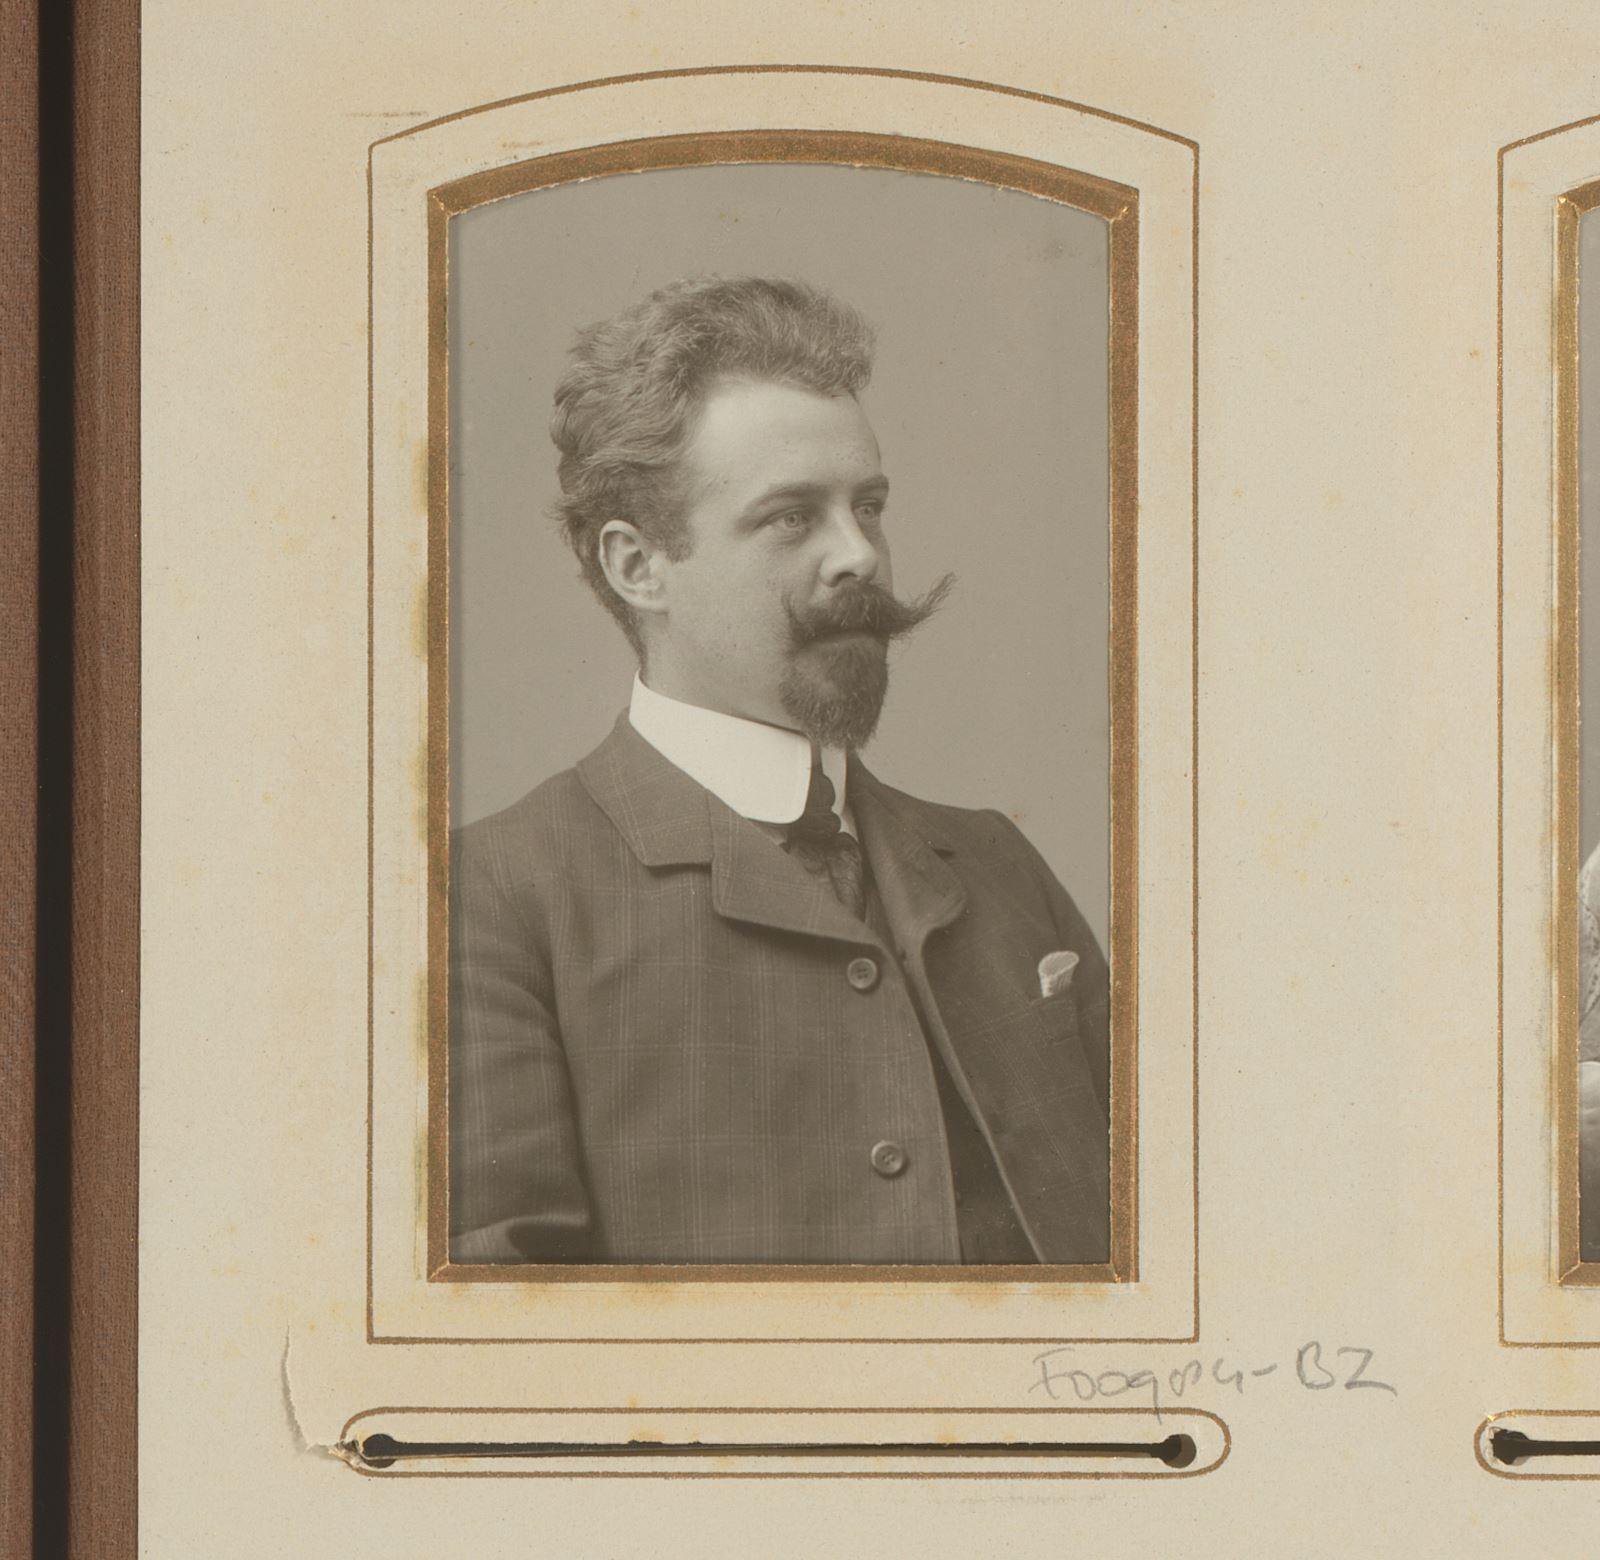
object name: album leaf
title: Portret van een man met snor en sik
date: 1905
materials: cardboard, photographic support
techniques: collodion silver print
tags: moustache, historical persons, beard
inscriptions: date: ‘1905’, inscription: ‘J.C. Reesinck/ Zutphen - Deventer/ Het cliché blijft voor nabestelling bewaard./ Speciale inrichting/ voor het vergrooten/ in onveranderlijke Kooldruk/ en Platina.’